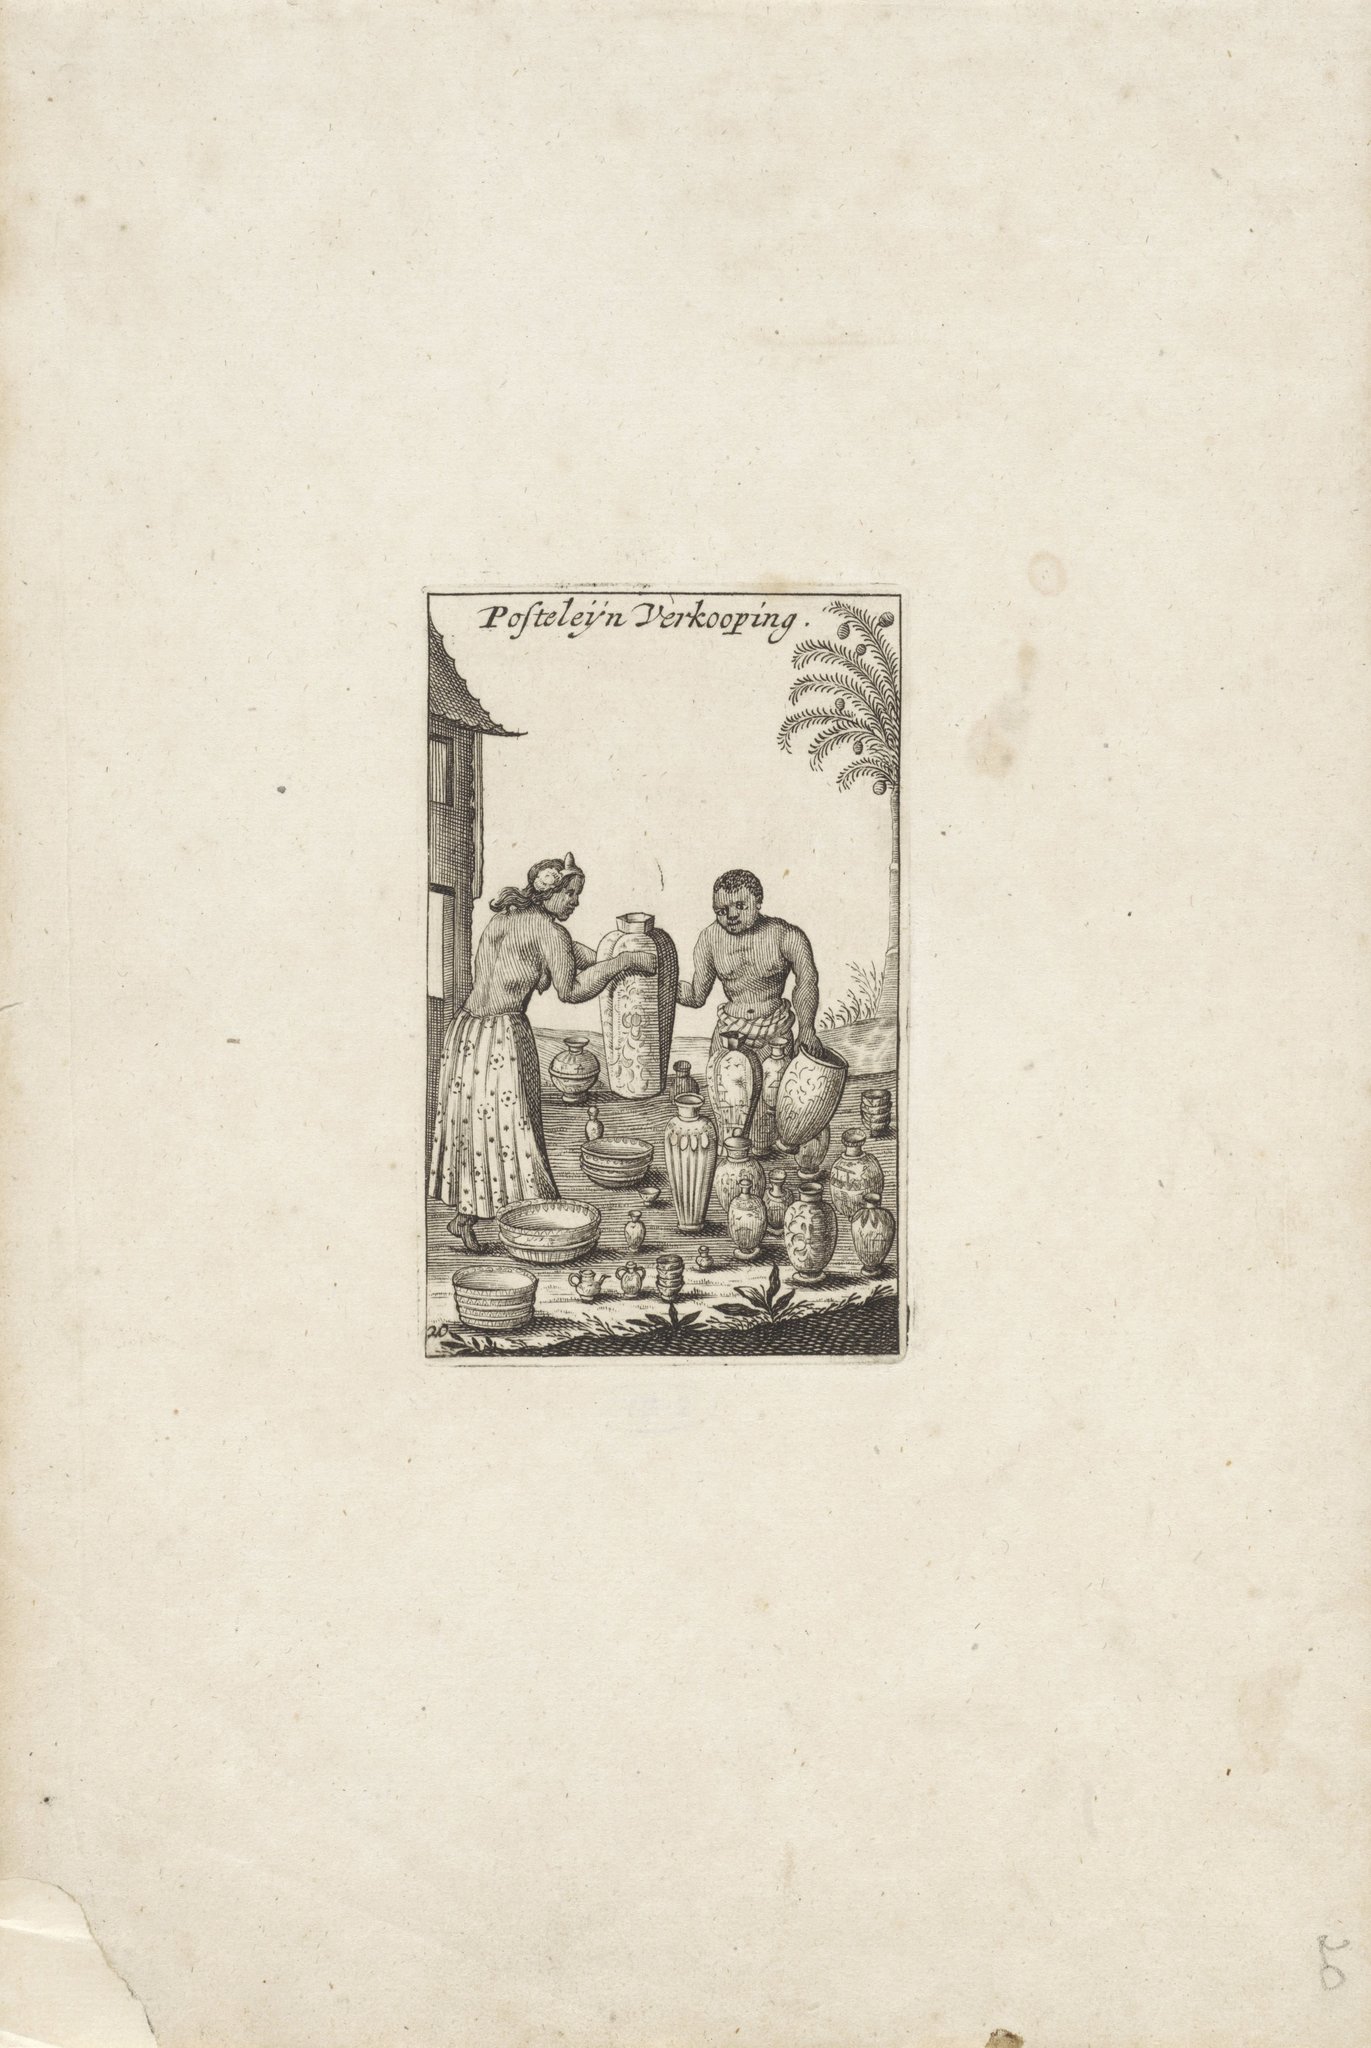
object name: print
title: Porcelain Sale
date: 1690-1713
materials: paper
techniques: etching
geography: amsterdam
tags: asiatic races and peoples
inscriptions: collector's mark: Lugt 2228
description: A topless man and woman lean over, evaluating a sea of Chinese porcelain. To meet the demand of ceramics in the Dutch Republic, the Dutch East India Company traded porcelain across an expansive network along the Indian Ocean Basin to the North Sea. Similar objects to those depicted in this print can be seen in the adjoining room.